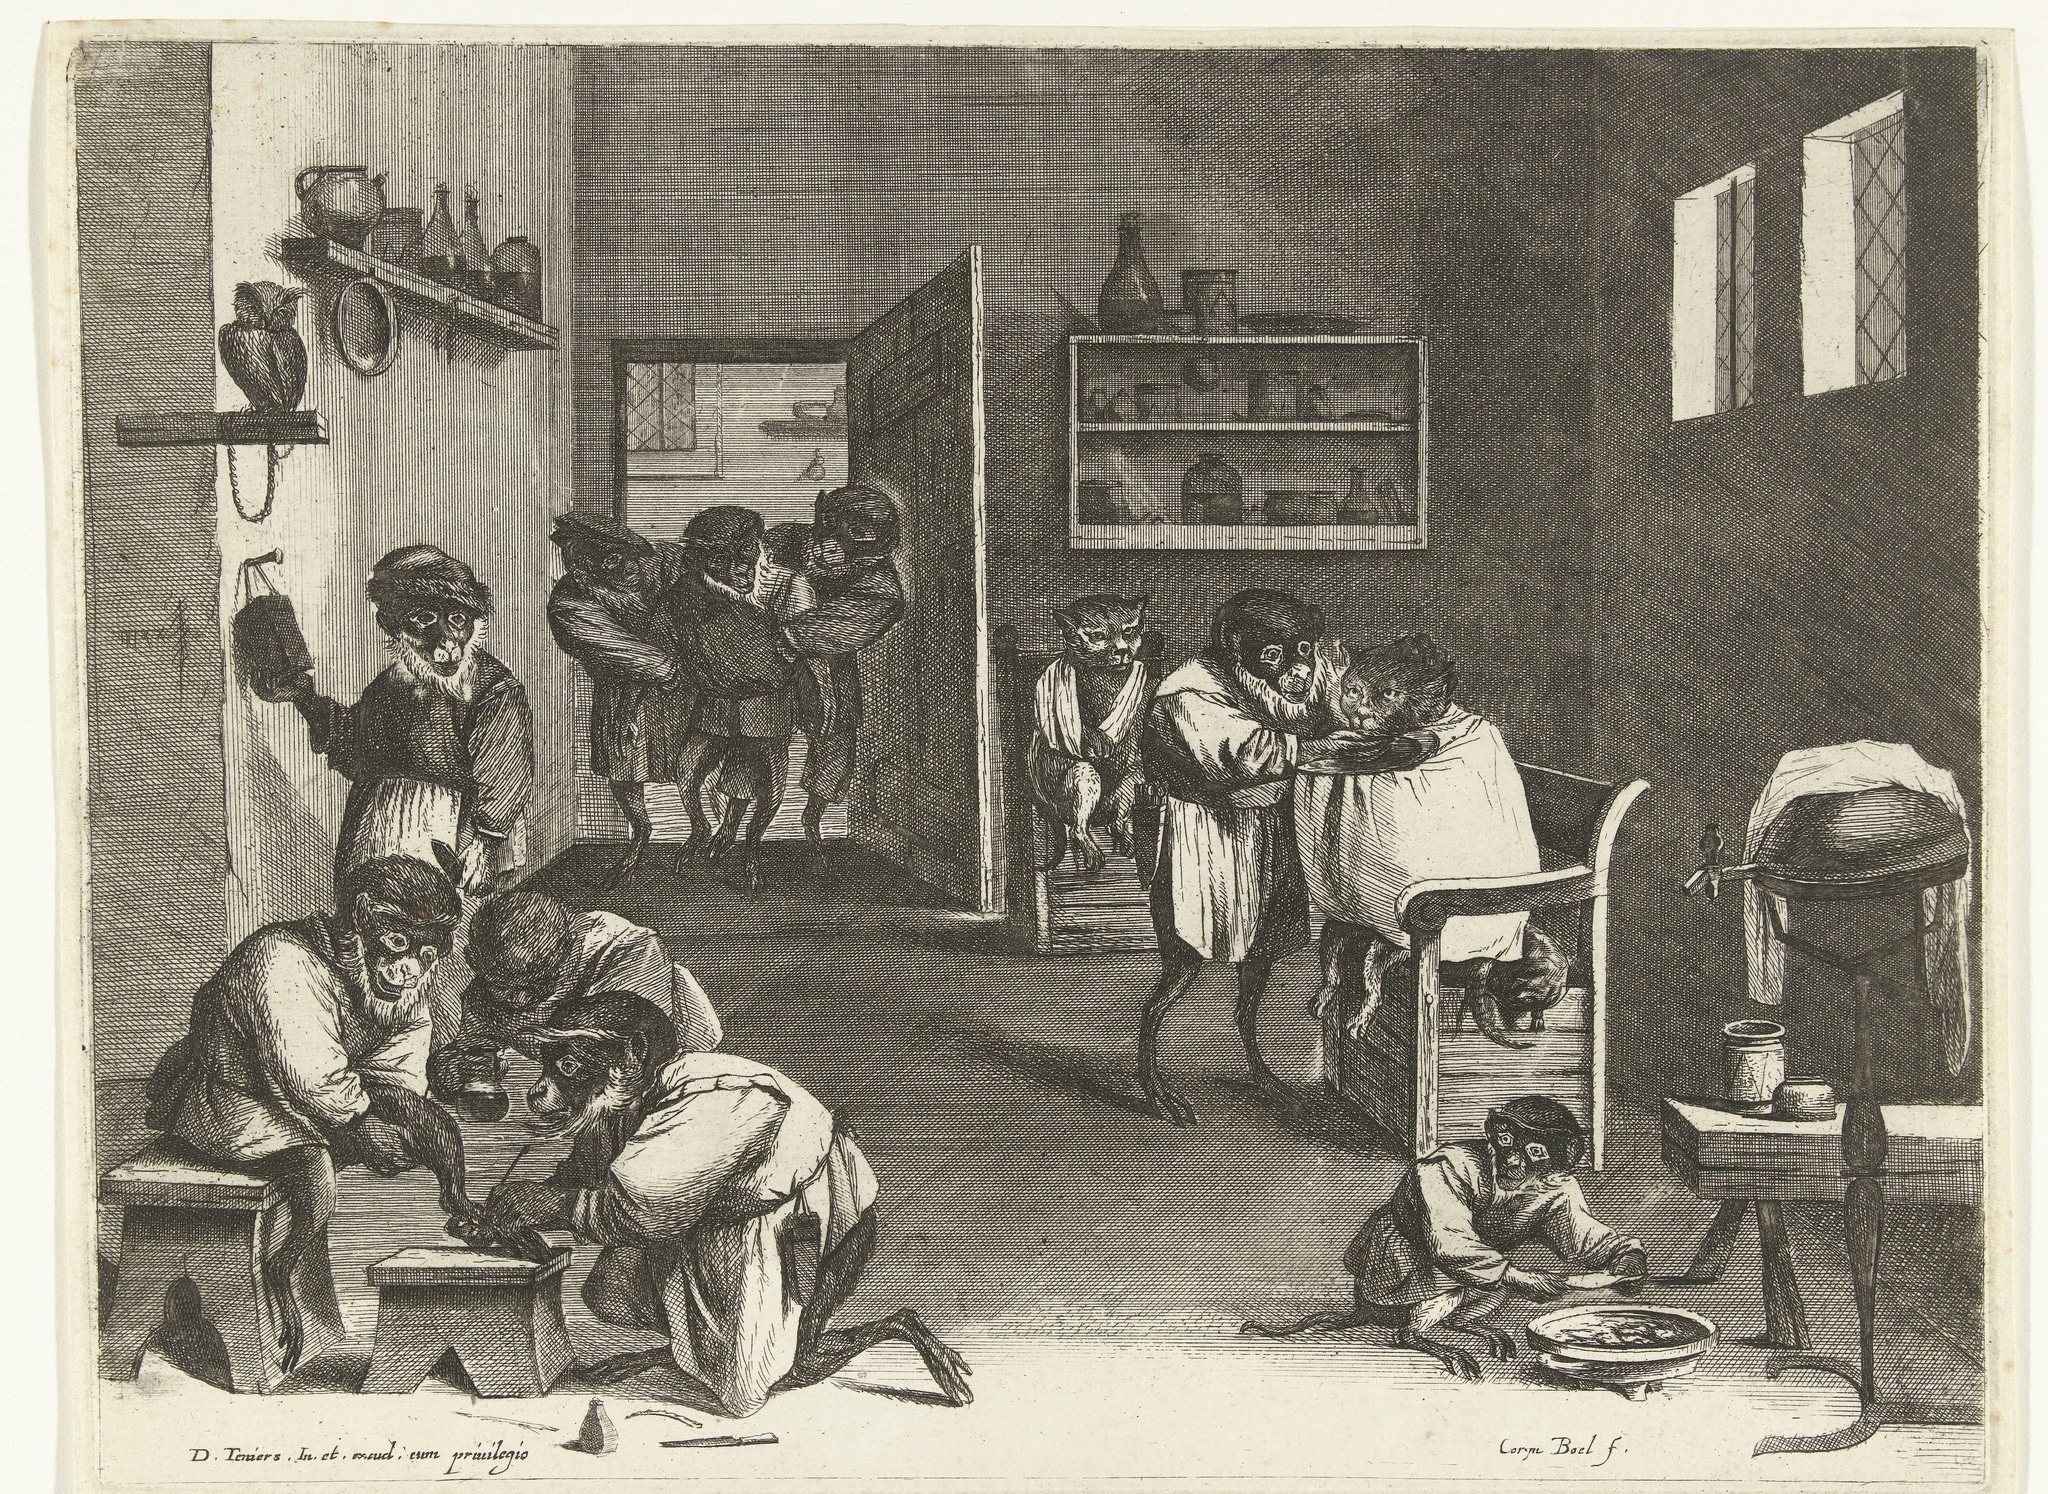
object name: print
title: Bij de chirurgijn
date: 1635-1668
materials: paper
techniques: etching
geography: southern netherlands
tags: animals acting as human beings, barber; surgeon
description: Singerie. In de behandelkamer van een chirurgijn worden verschillende klanten geholpen. Links voor krijgt een aap een tinctuur op zijn voet gestreken. Rechts wordt een aap gevoerd die compleet in het verband zit. Een andere klant zit met zijn arm in een doek te wachten.